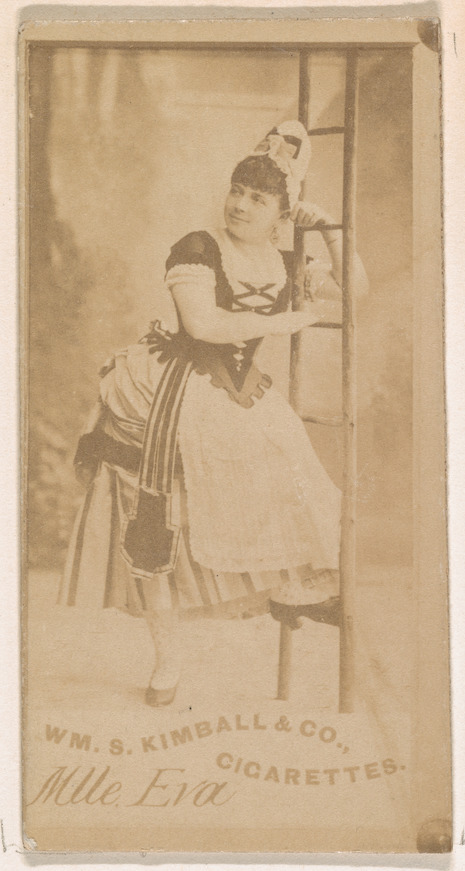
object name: photograph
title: Mlle. Eva, from the Actresses series (N203) issued by Wm. S. Kimball & Co.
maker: william s. kimball & company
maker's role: publisher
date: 1889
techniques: color lithograph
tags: portraits,women,actresses